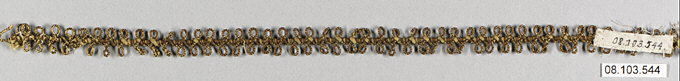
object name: galloon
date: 1734-1766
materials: metal thread